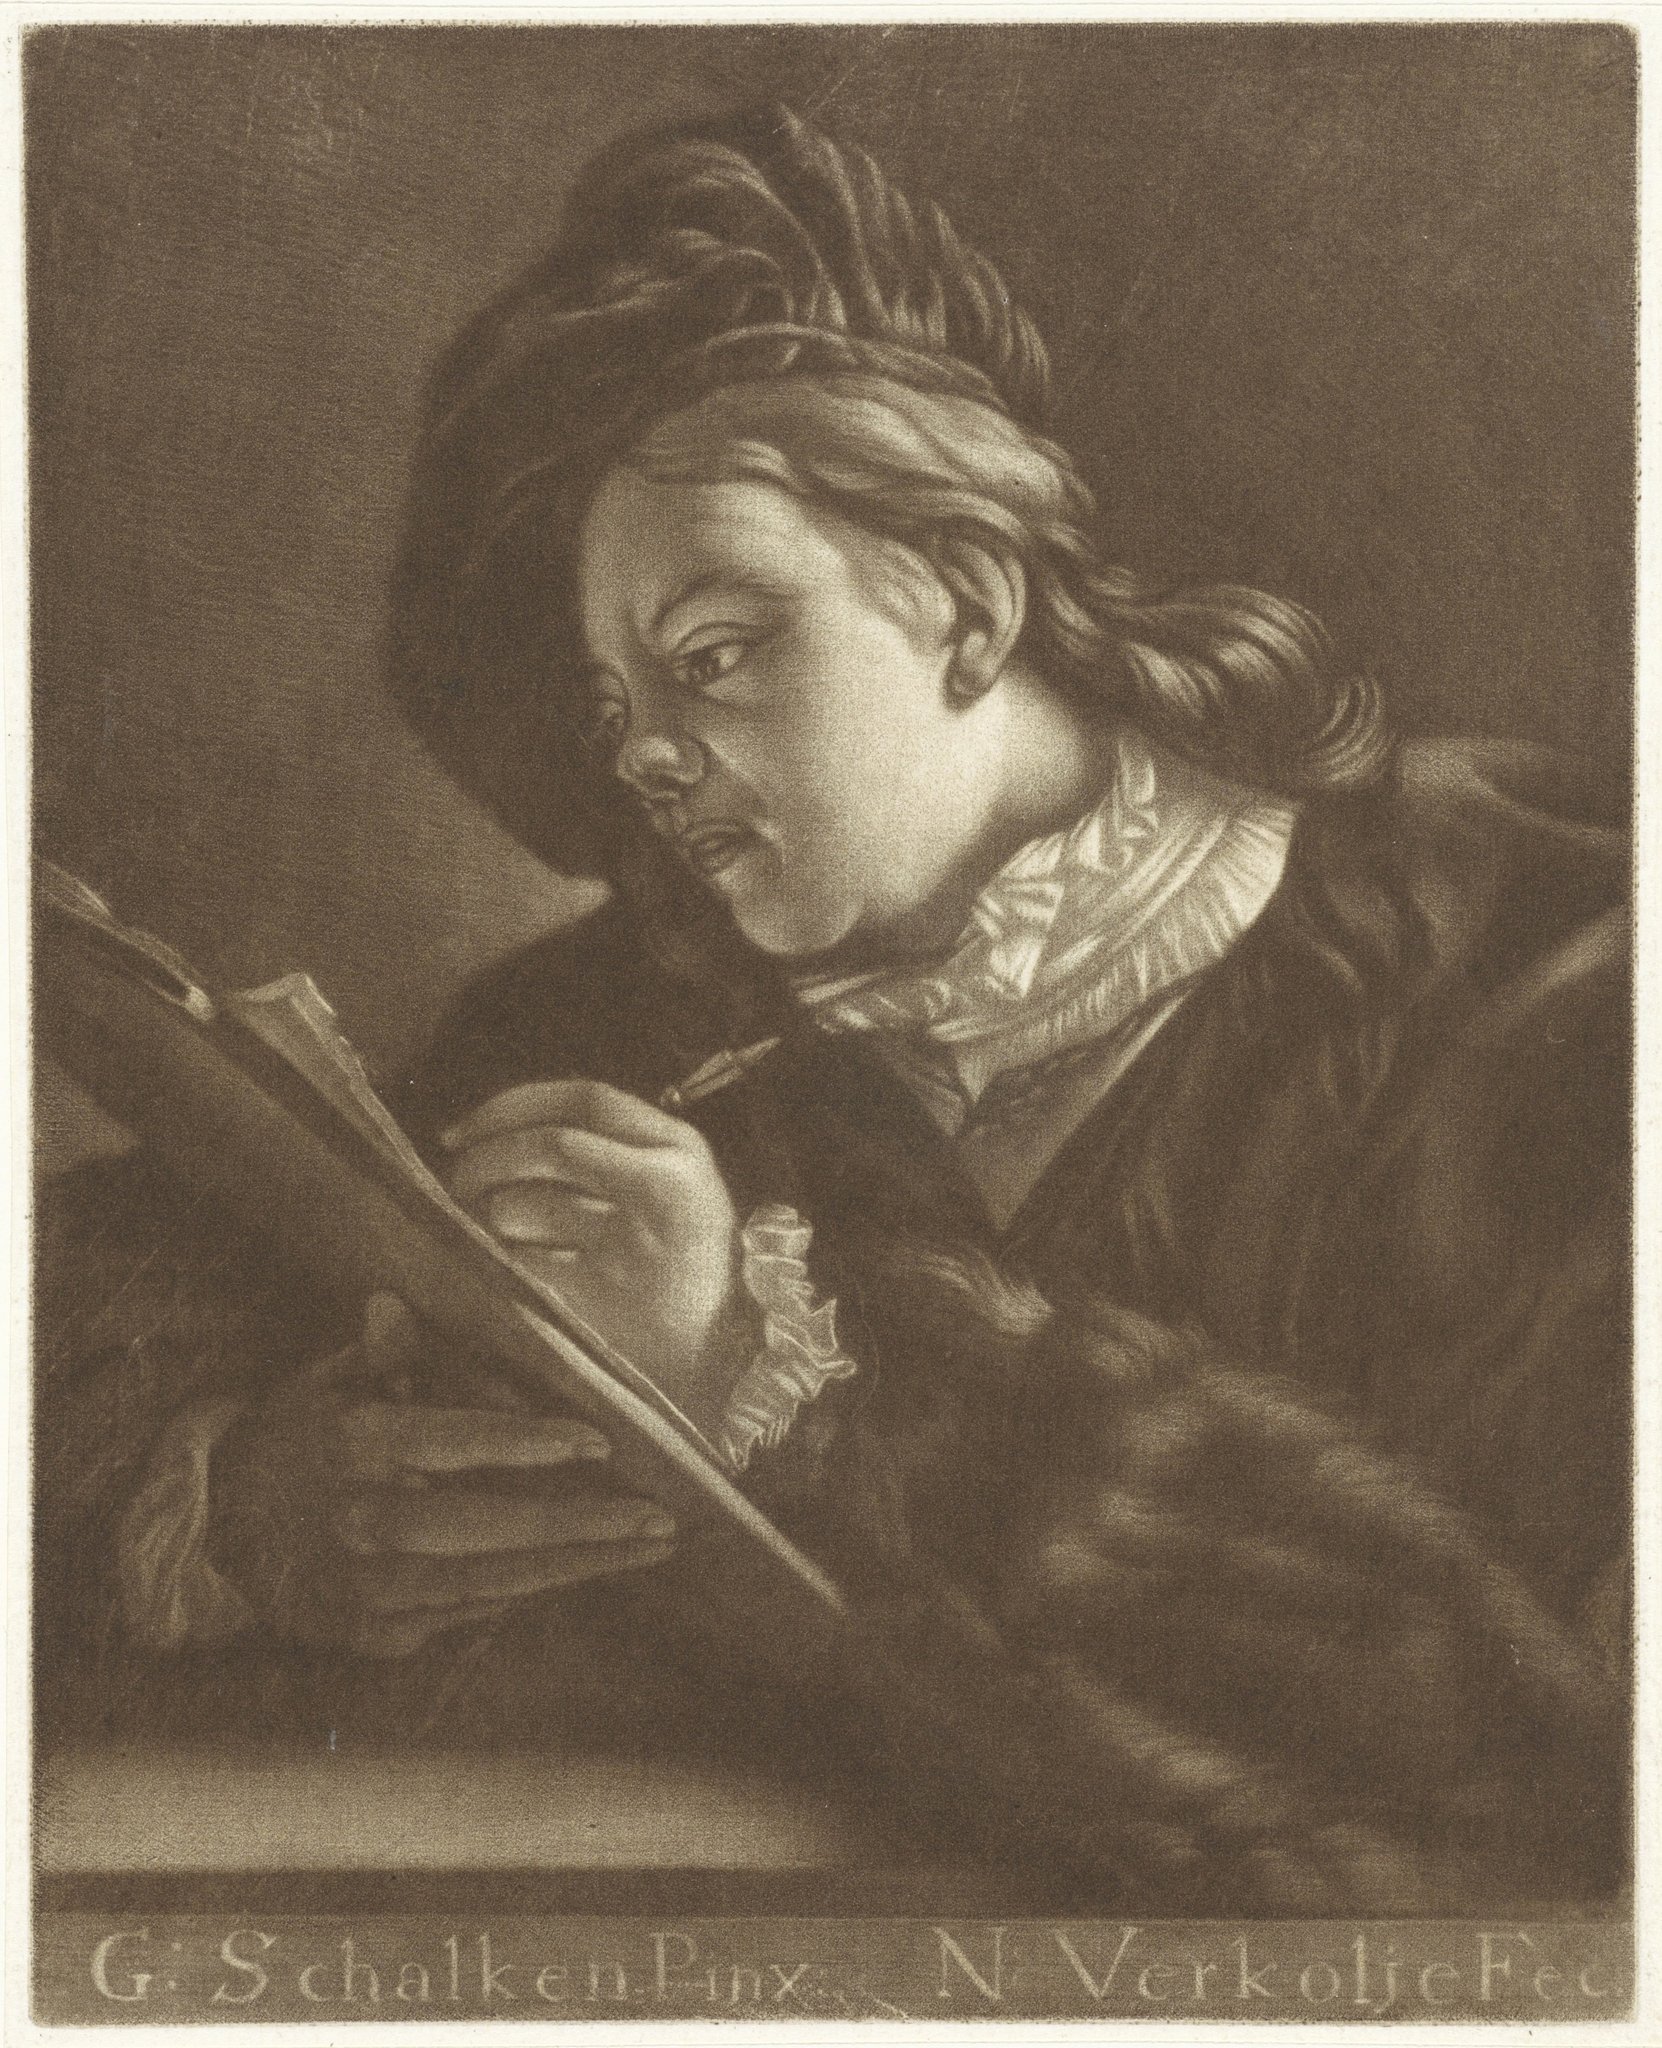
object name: print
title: Tekenaar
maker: jan stolker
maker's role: draughtsman, painter, print maker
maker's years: 1724-1785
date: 1734-1785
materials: paper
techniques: mezzotint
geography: northern netherlands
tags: head-gear: cap (+ men's clothes), draughtsman at work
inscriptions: collector's mark: Lugt 240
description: Een jongen tekent geconcentreerd op het blad dat hij op een plankje voor zich houdt. Hij draagt een muts.